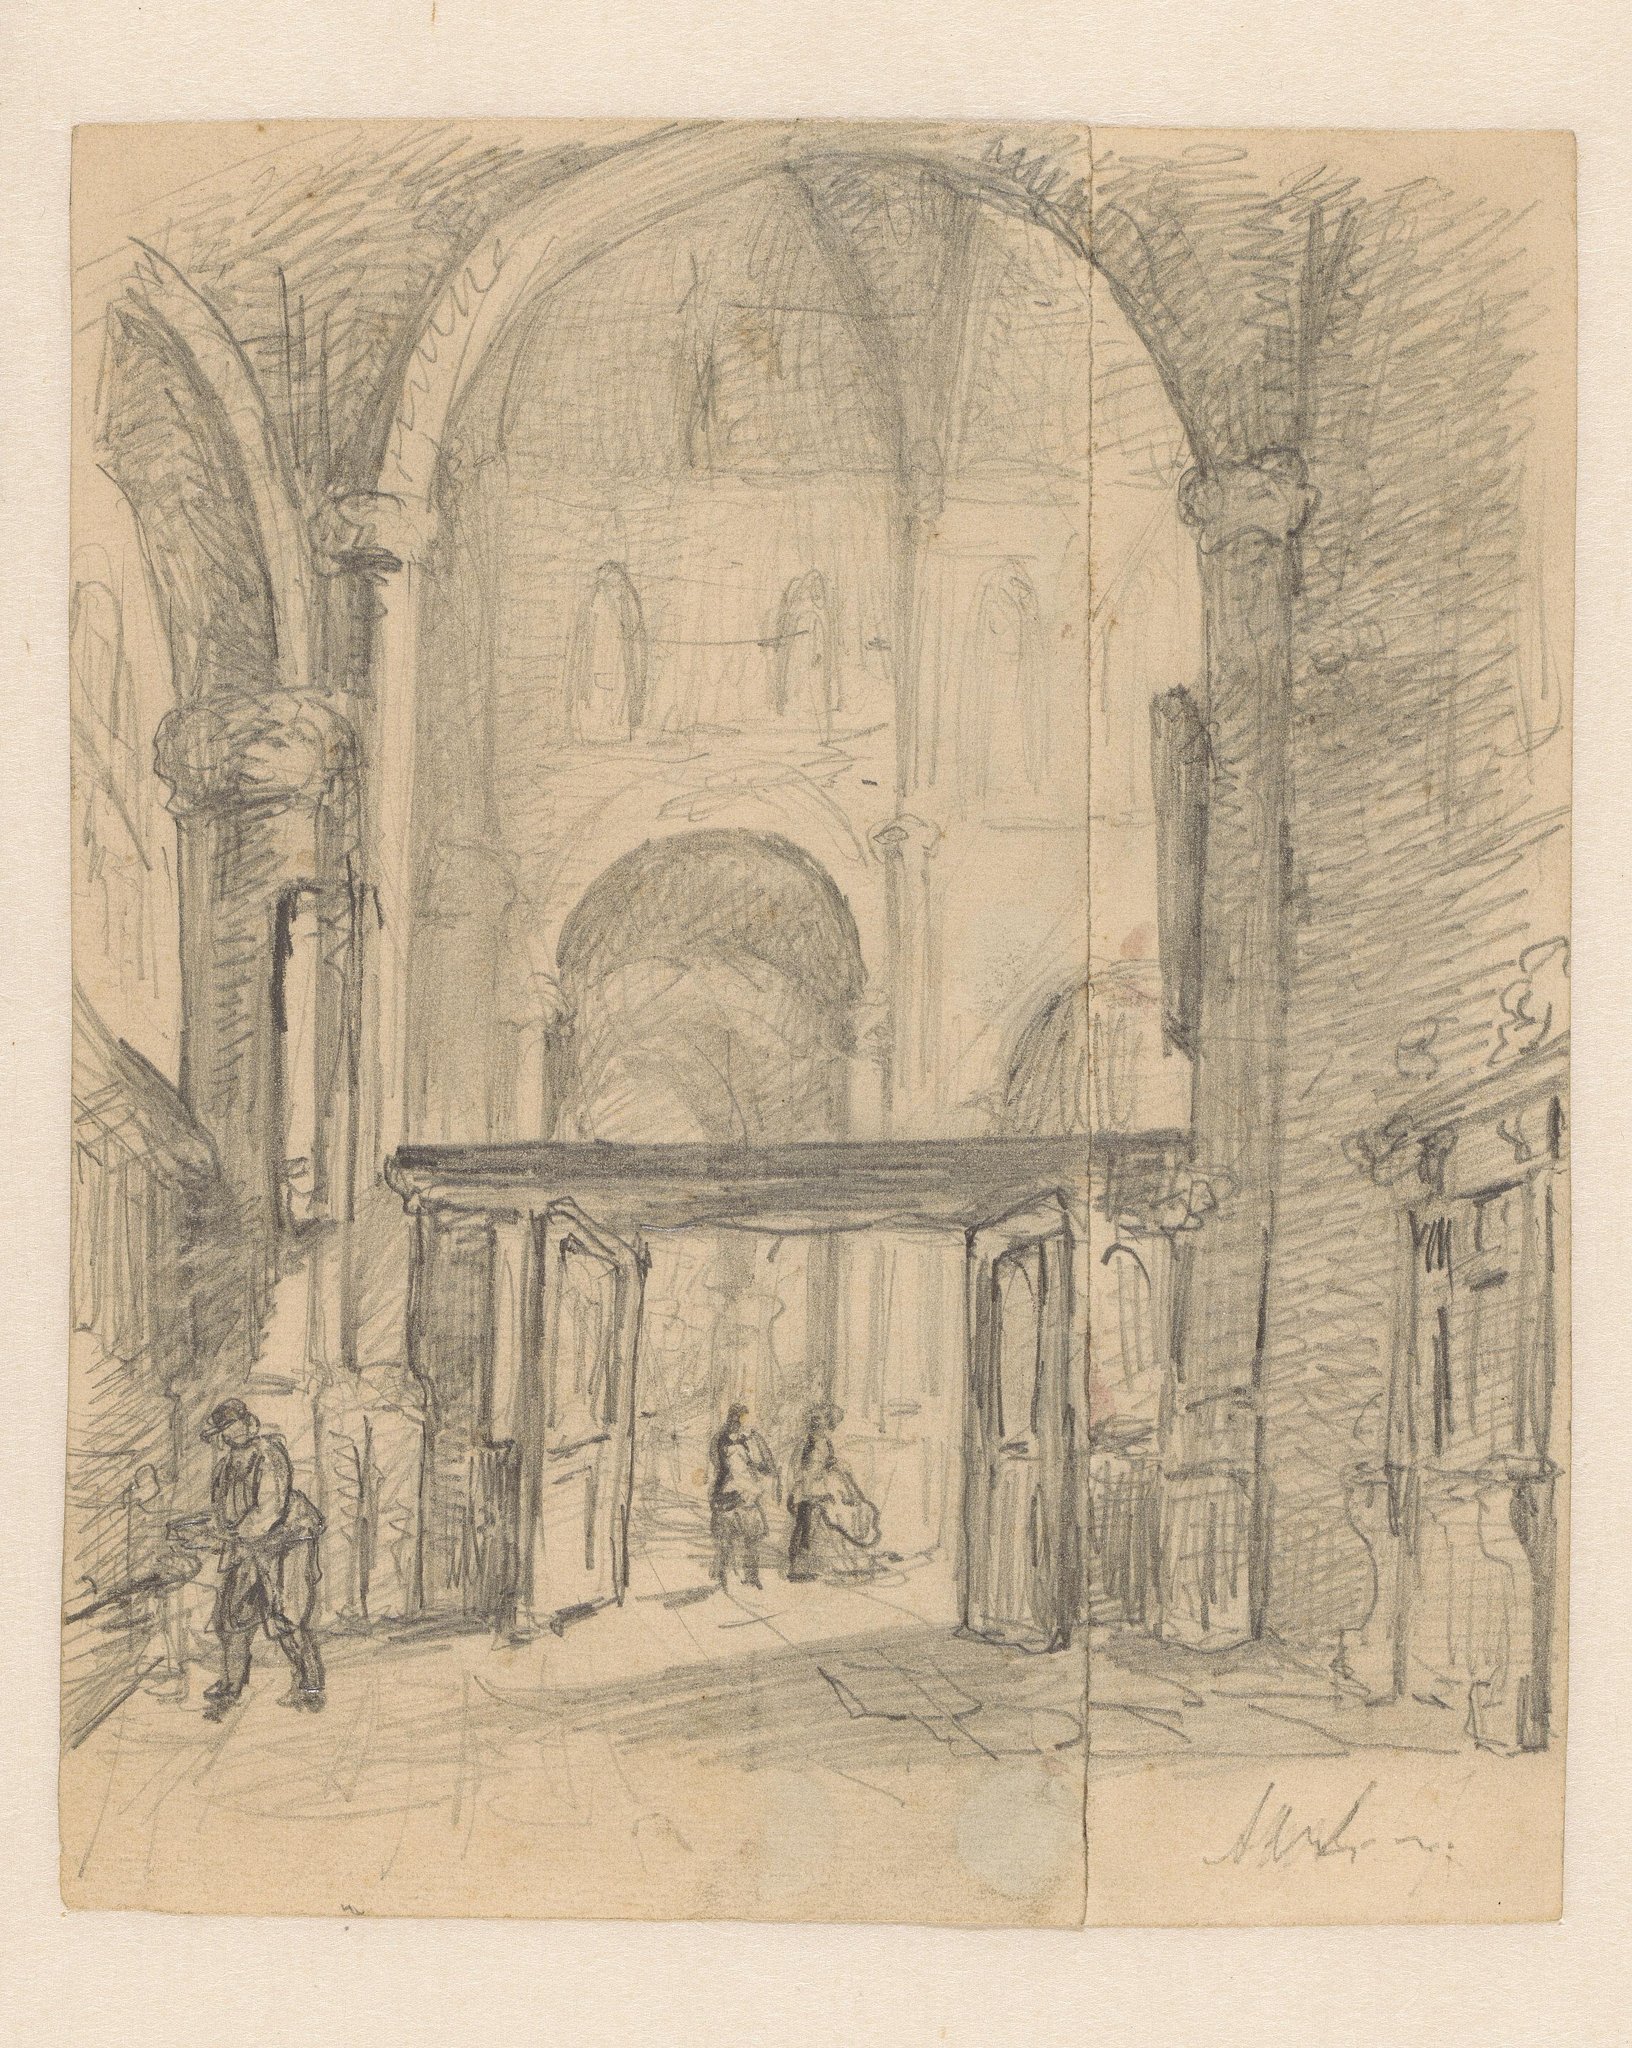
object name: drawing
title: Interieur van de St.-Eusebiuskerk te Arnhem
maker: Anonymous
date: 1800-1900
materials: paper, pencil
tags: interior of church, arnhem